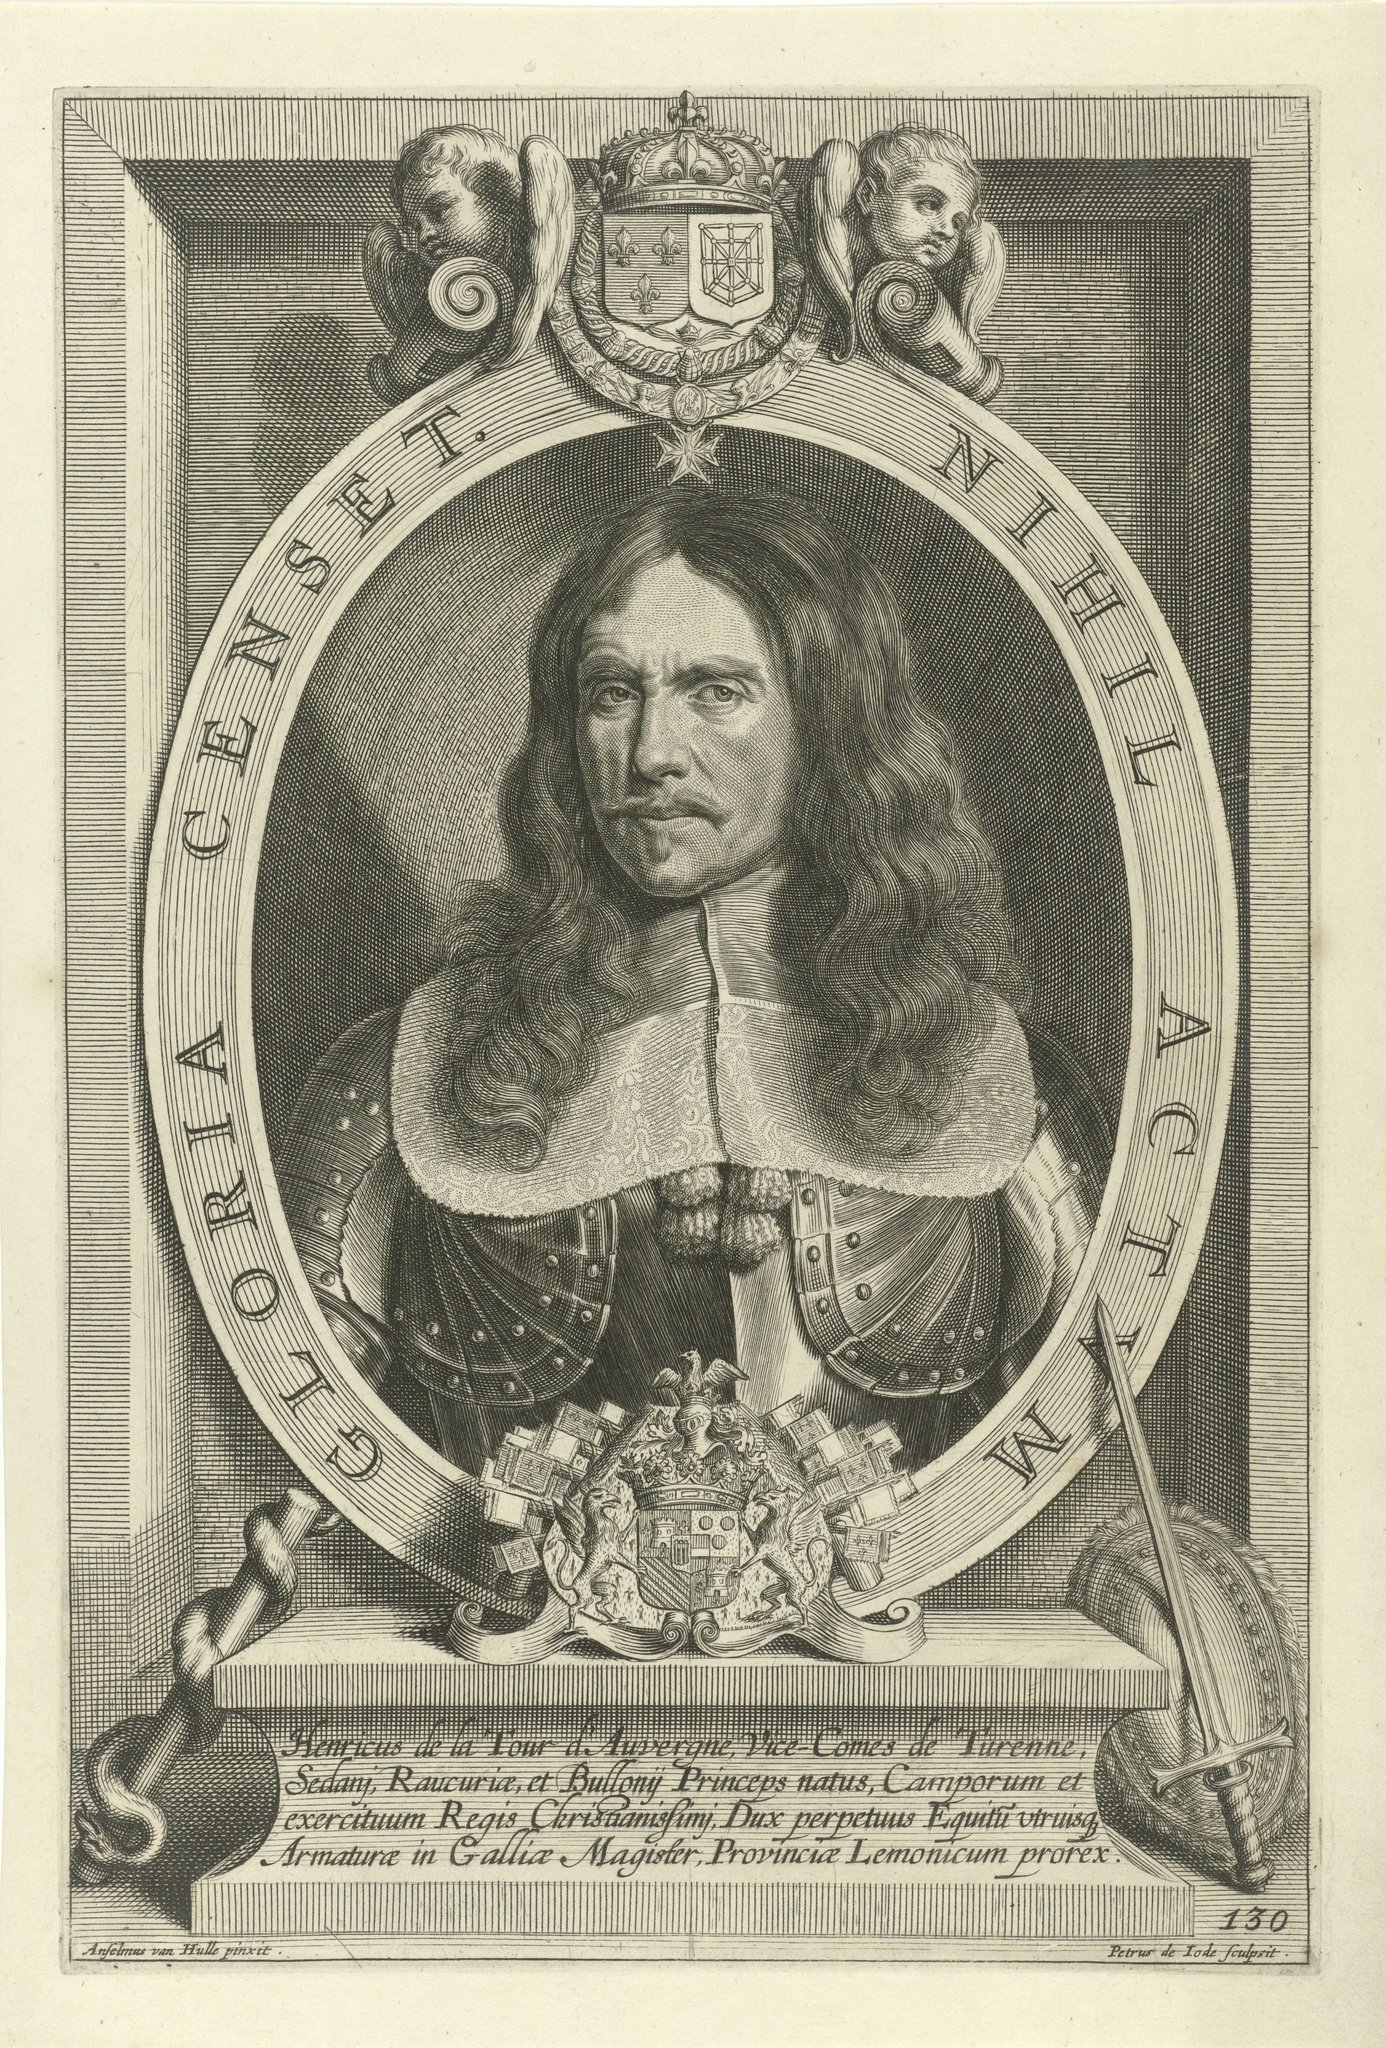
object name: print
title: Hommes illustres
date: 1628-1670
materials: paper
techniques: engraving, etching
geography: antwerp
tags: armour, knighthood order of the holy spirit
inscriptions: collector's mark: Lugt 2228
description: Busteportret van Henri de Latour d'Auvergne, in harnas. Rechtsonder: 130. Het portret is gevat in een ovale omlijsting met het wapenschild van de geportretteerde, een keten met de Orde van de Heilige Geest en een randschrift in het Latijn. In het kader een vierregelig onderschrift in het Latijn. Op de voorgrond een stok met een slang en een zwaard met een schild. Prent uit een serie portretten naar schilderijen van Anselmus van Hulle van alle gedelegeerden bij de vredesonderhandelingen te Münster en Osnabrück.